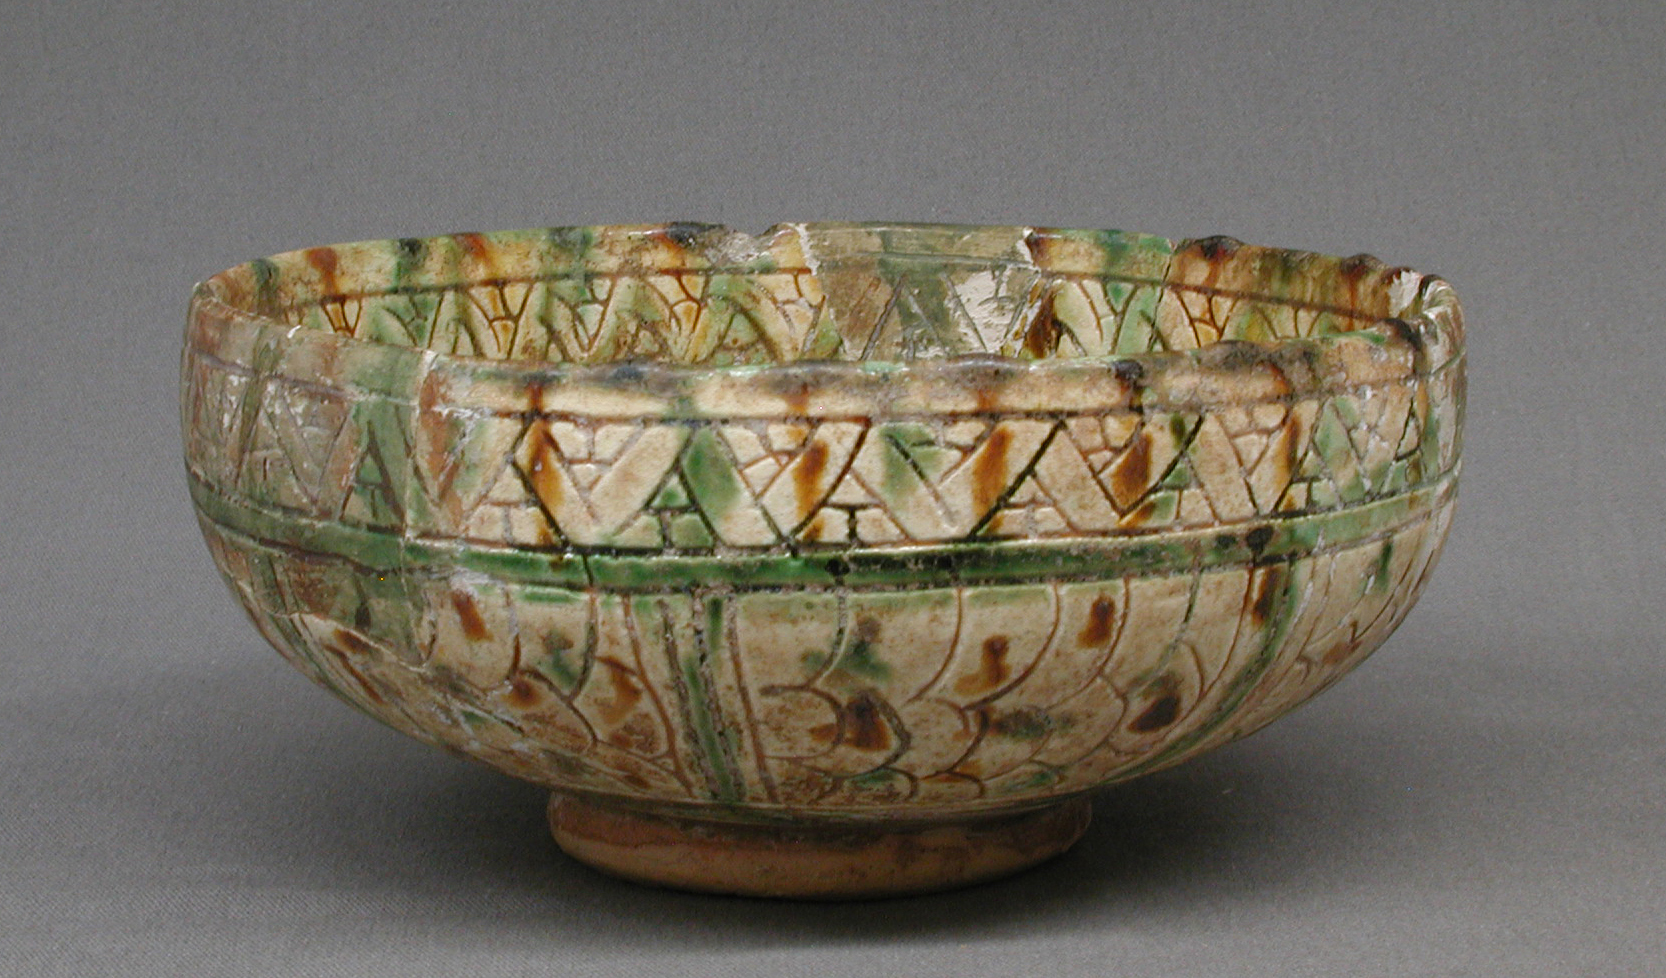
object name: bowl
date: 1501-1550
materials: earthenware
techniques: glazing